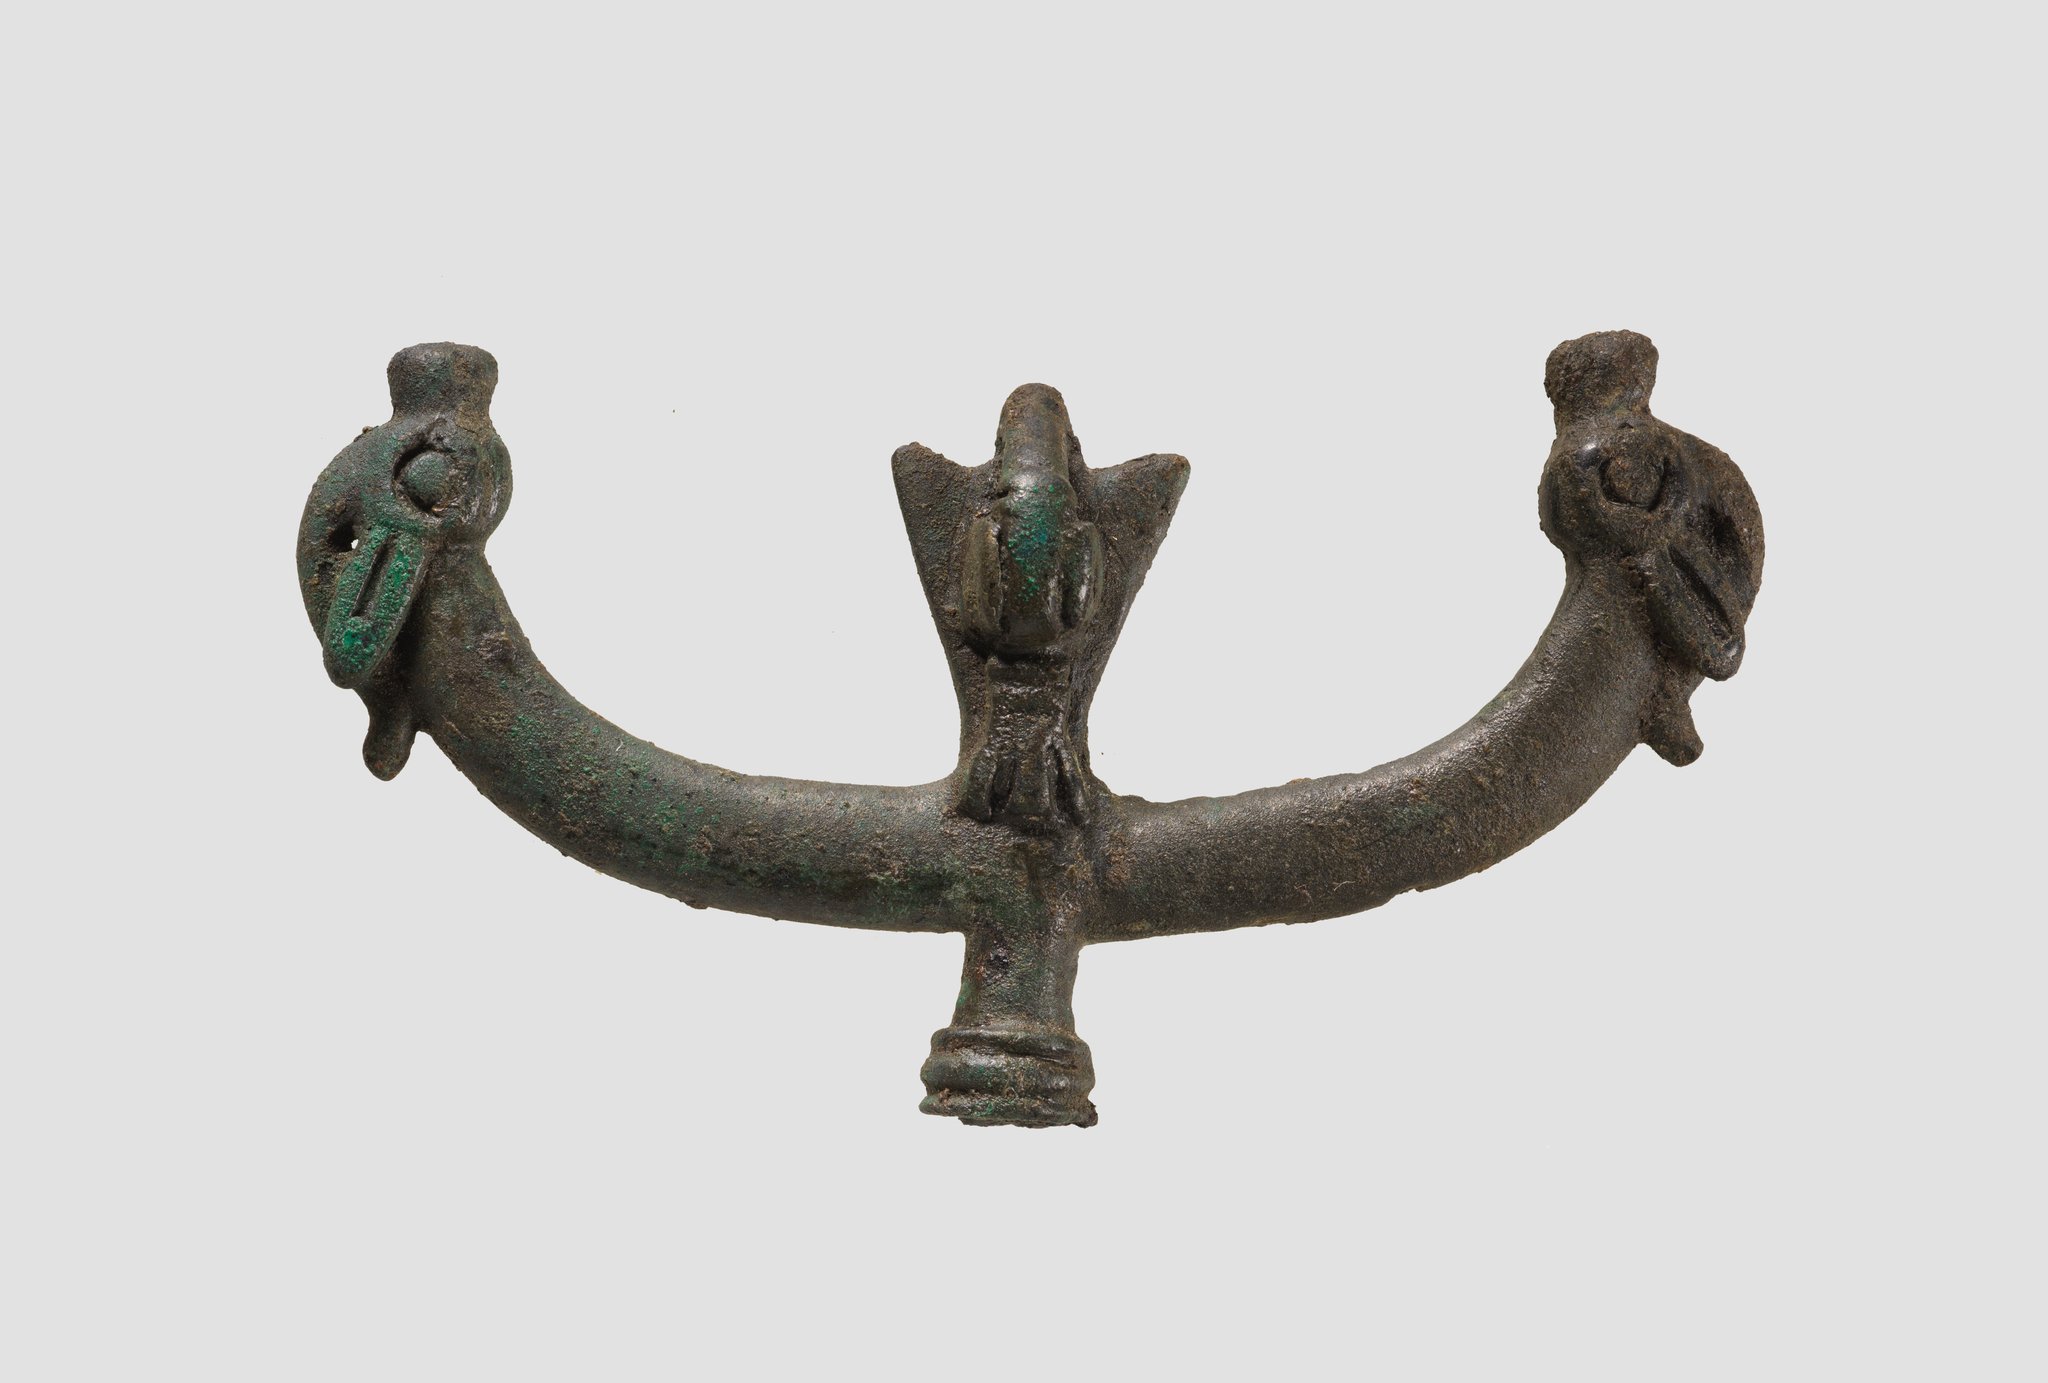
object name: pin head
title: Head of pin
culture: iranian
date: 800-601 BCE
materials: bronze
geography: iran, luristan